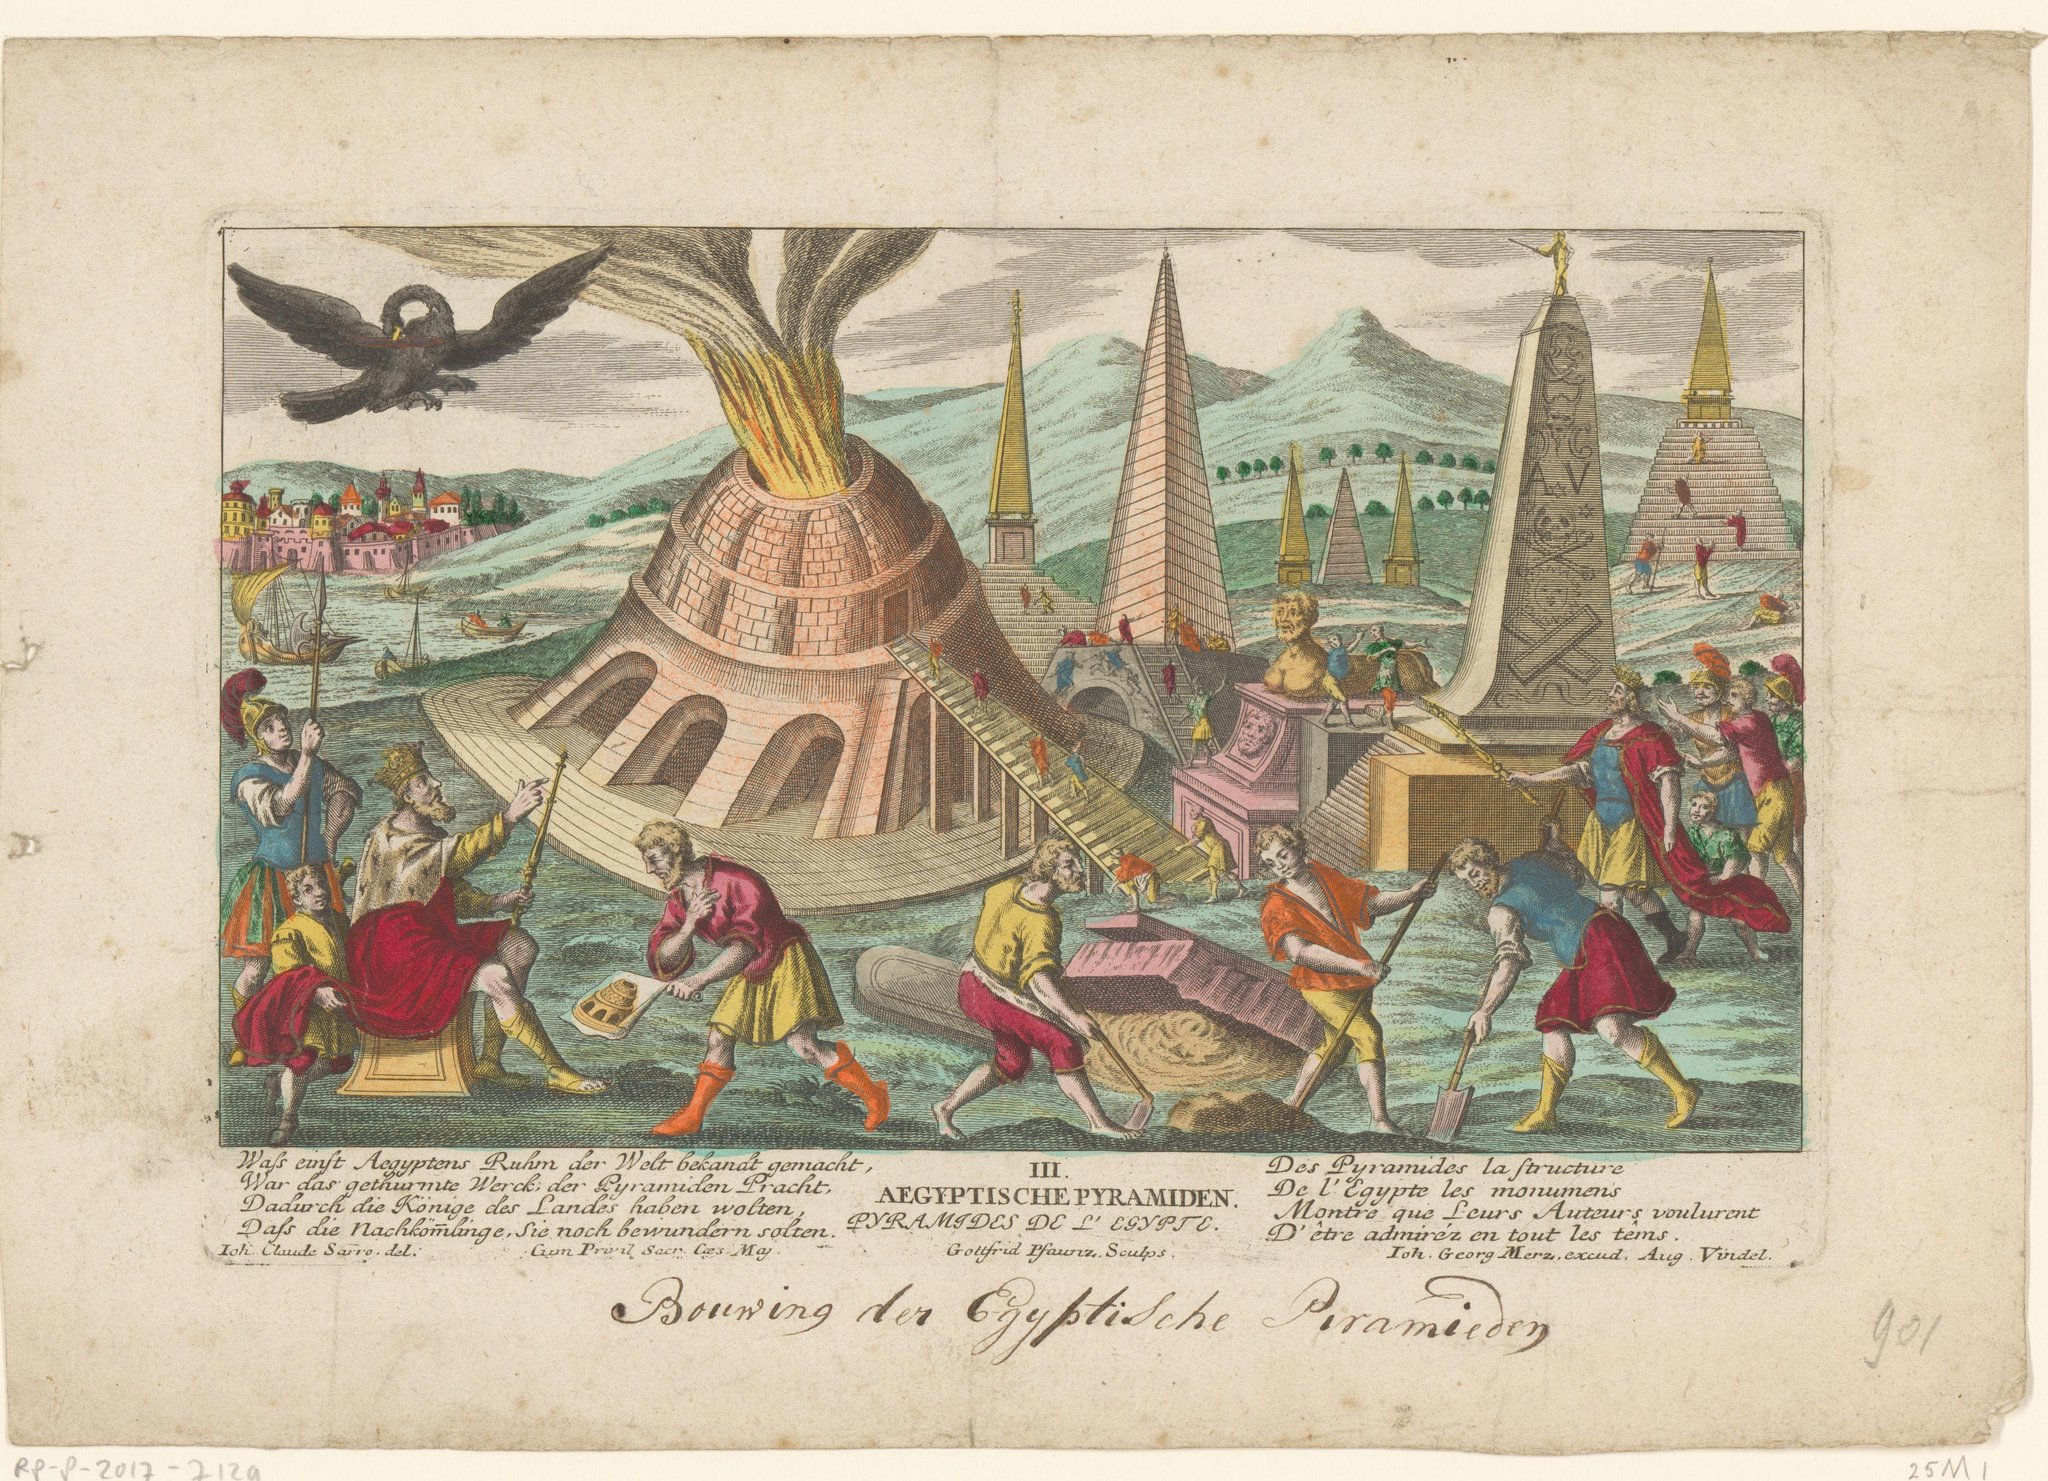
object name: print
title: Aegyptische pyramiden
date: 1709-1762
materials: paper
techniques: engraving, etching, hand coloring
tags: egyptian pyramids (wonder of the world), ruler, sovereign, building-site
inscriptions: collector's mark: Lugt 2228, : ‘Bouwing der Egyptische Piramieden’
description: Fantasievoorstelling van de bouw van Egyptische piramides waarbij een grote steenoven wordt gebouwd waar de vlammen uit slaan. Links worden plannen gepresenteerd aan een vorst.